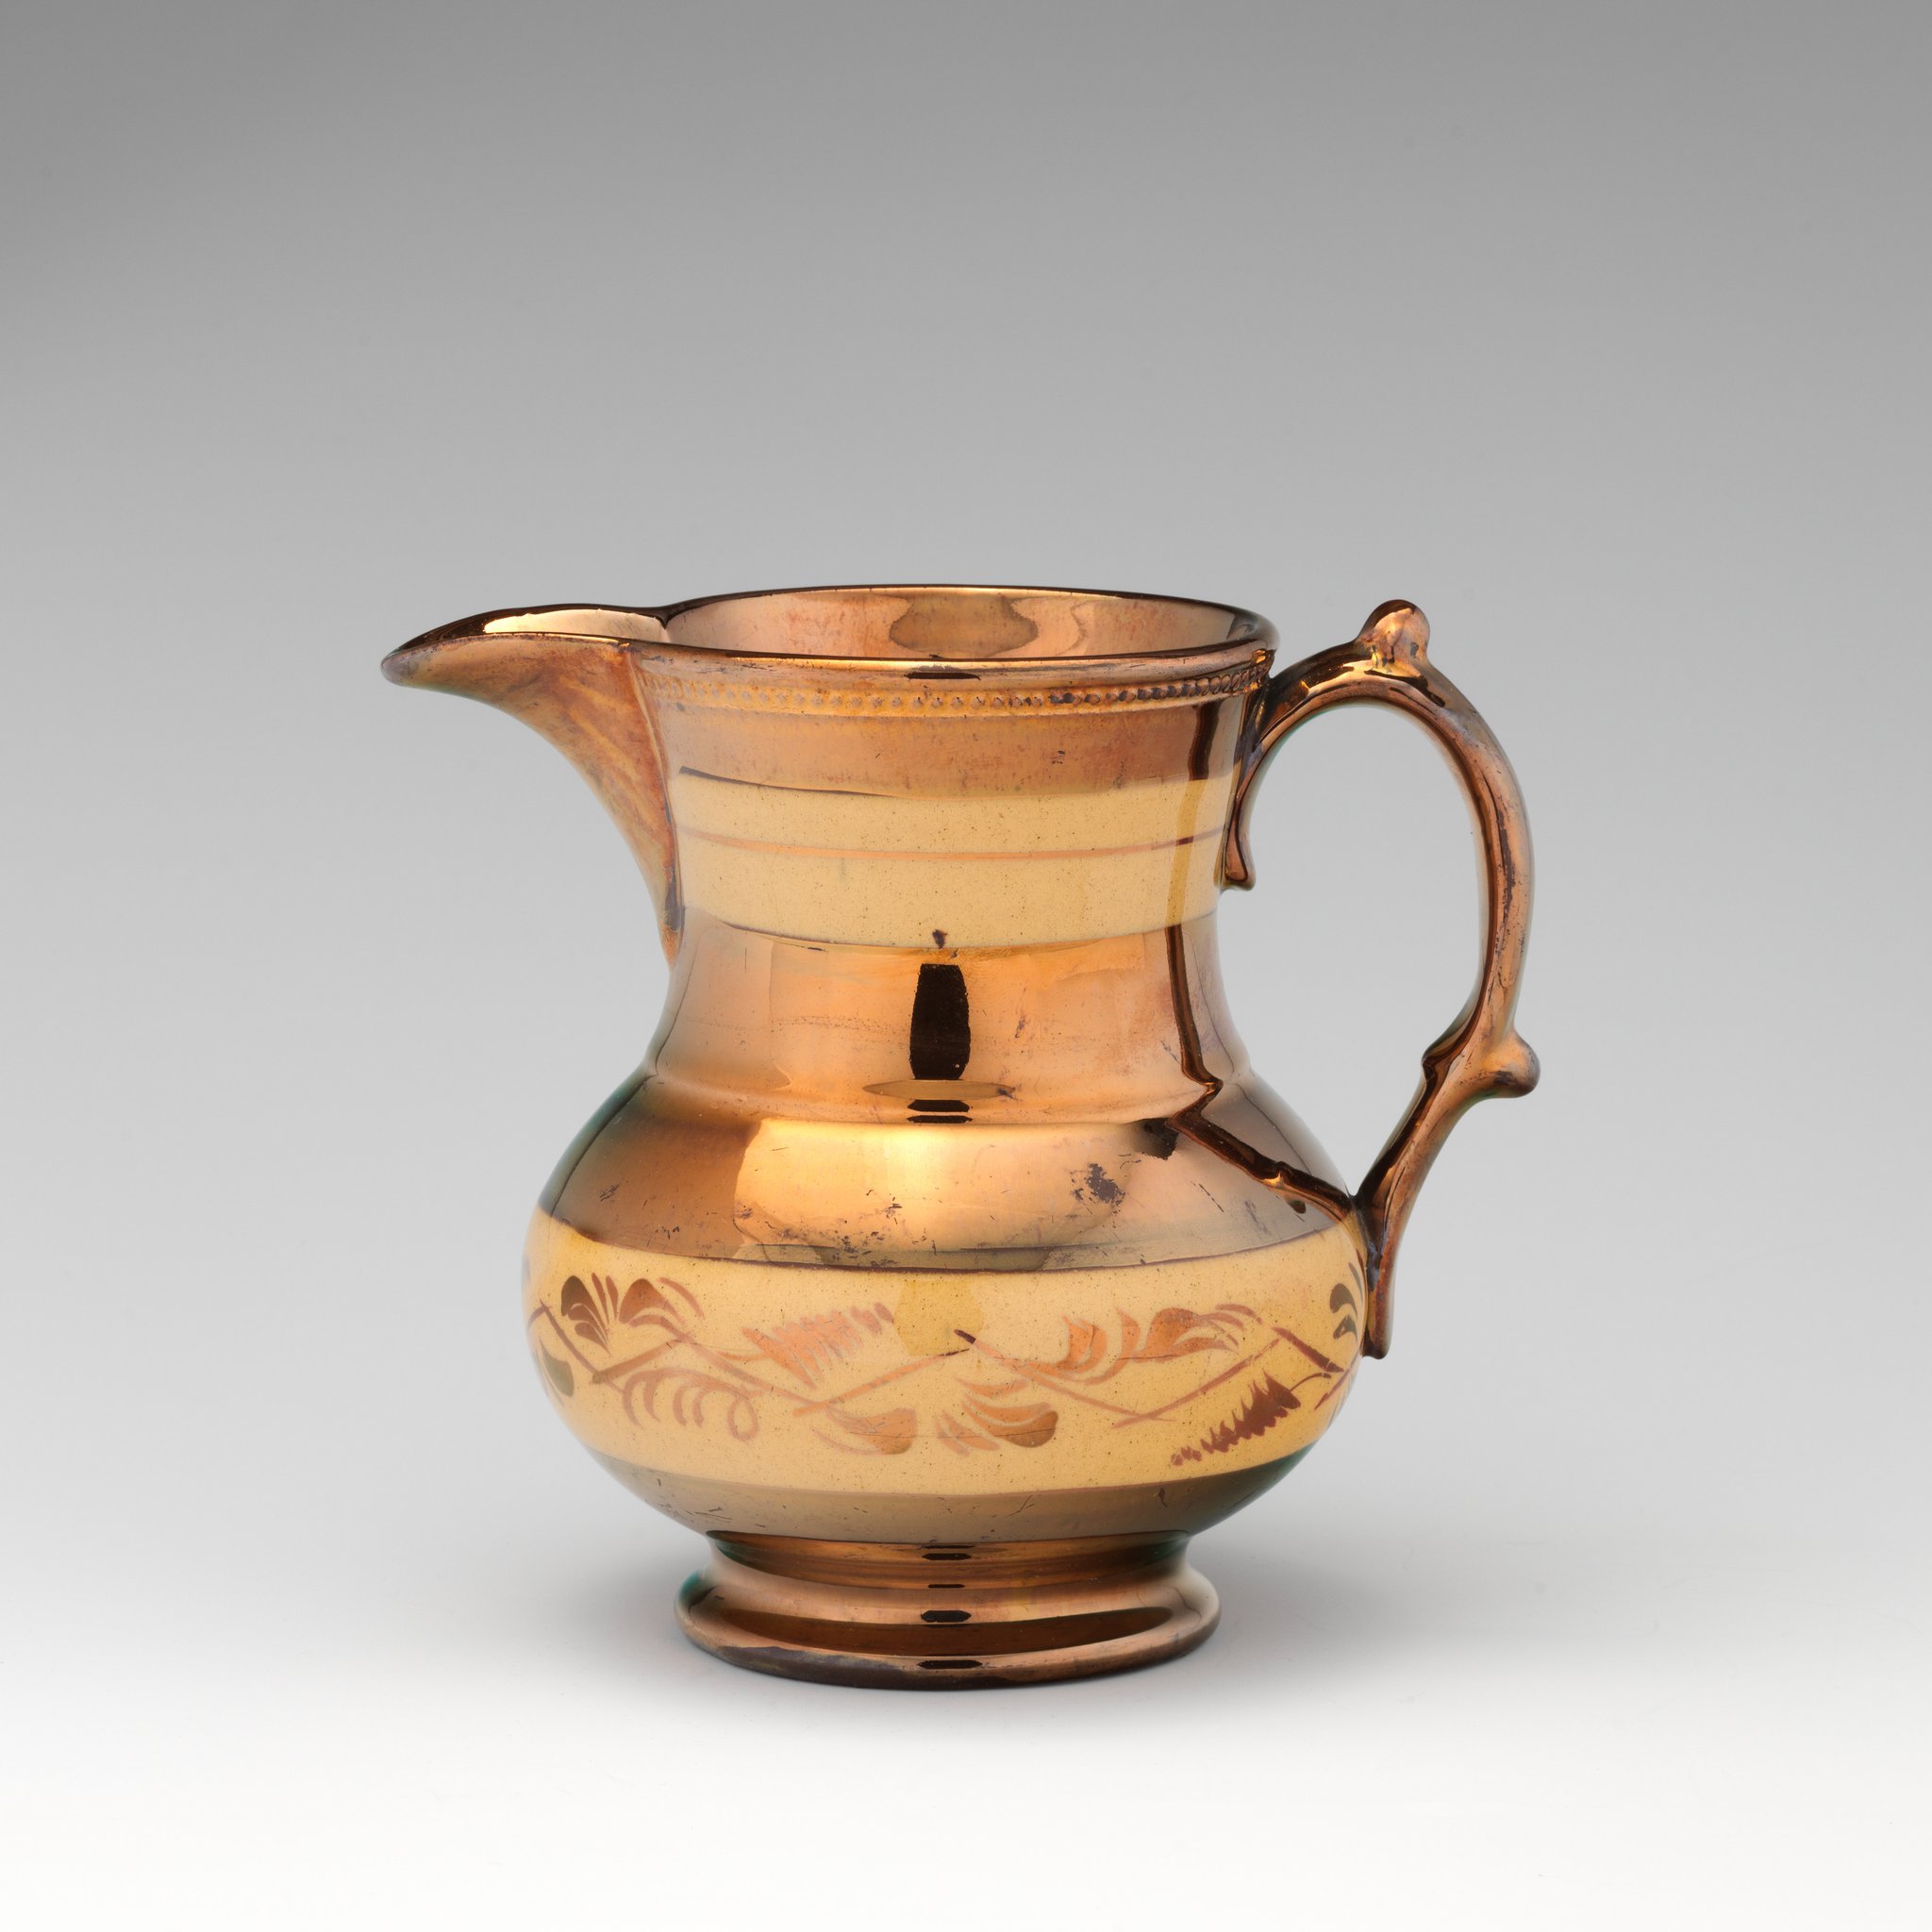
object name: jug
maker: tunstall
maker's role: maker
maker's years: 1800-1900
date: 1801-1900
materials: pottery